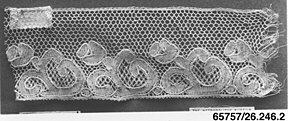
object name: strip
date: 1801-1900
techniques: lace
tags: flowers